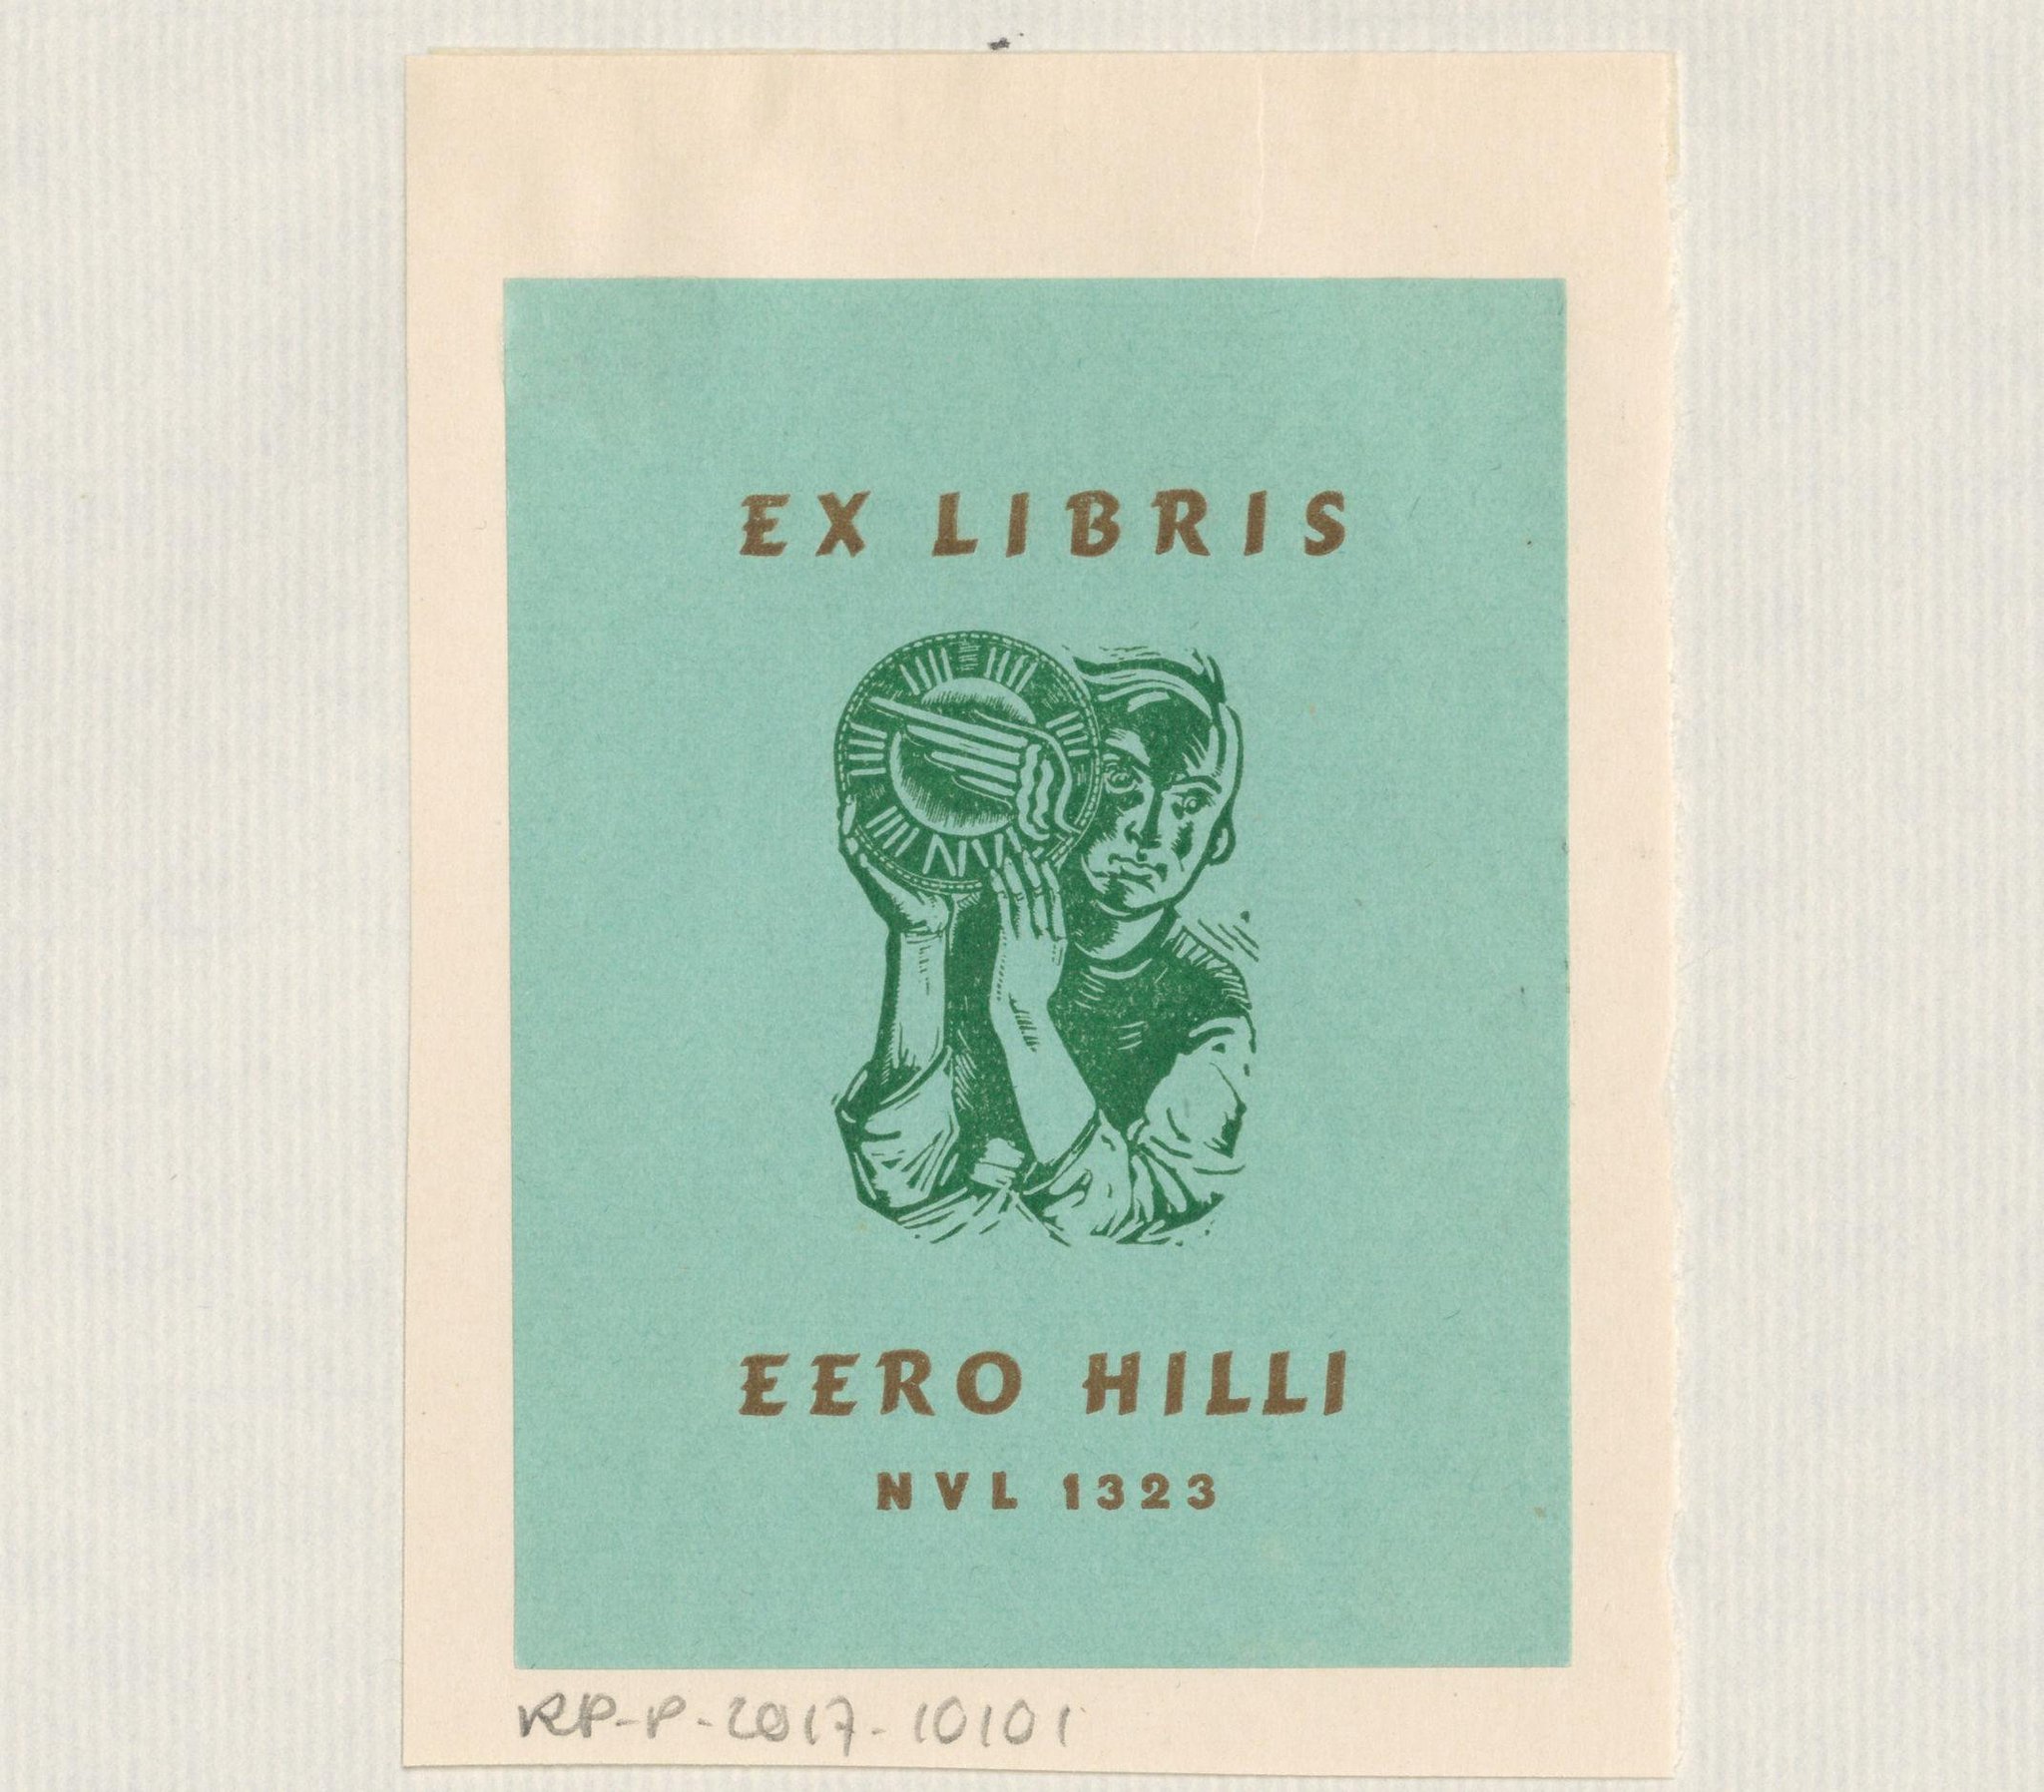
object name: bookplate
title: Ex libris van Eero Hilli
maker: Anonymous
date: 1900-1999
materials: paper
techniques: printing block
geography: finland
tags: standing figure, film, celluloid